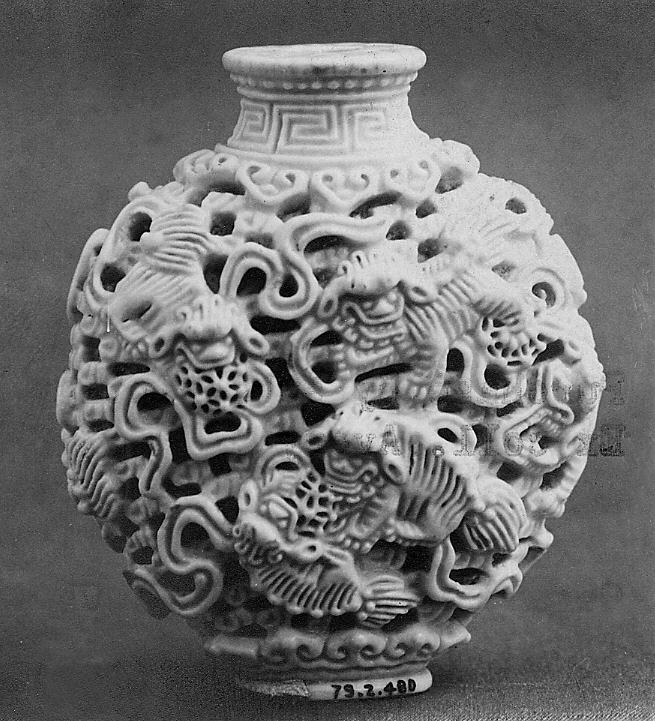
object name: snuff bottle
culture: chinese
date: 1701-1800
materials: porcelain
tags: animals